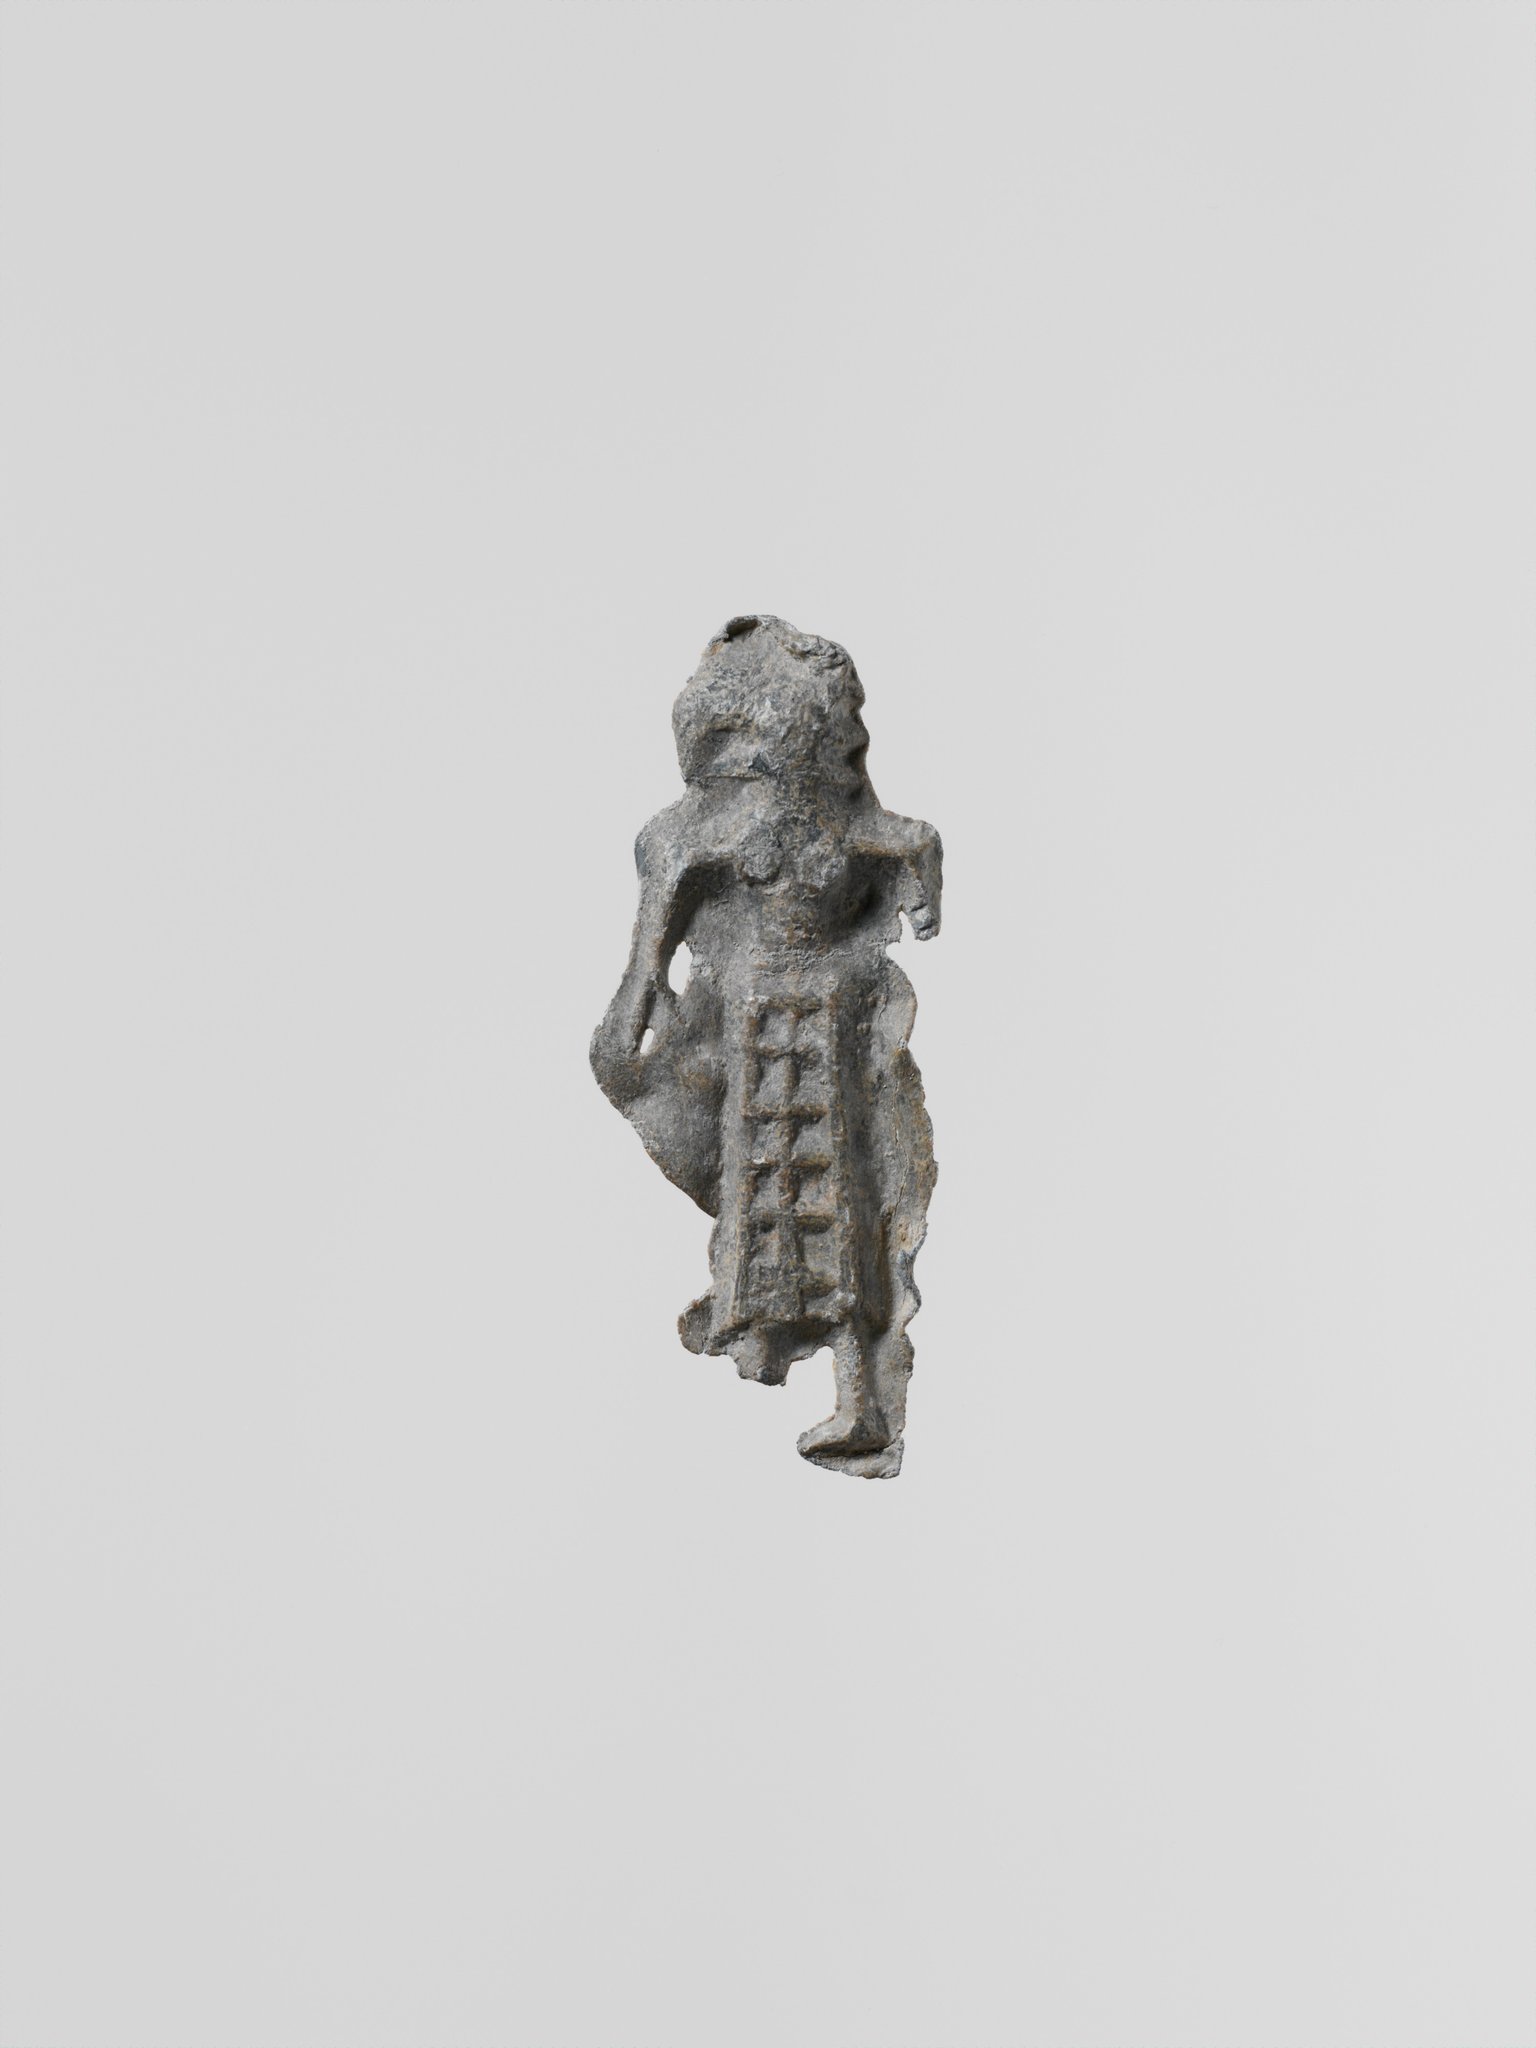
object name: statuette of a woman votary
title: Lead figure of a woman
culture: greek, laconian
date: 634-568 BCE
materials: lead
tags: women